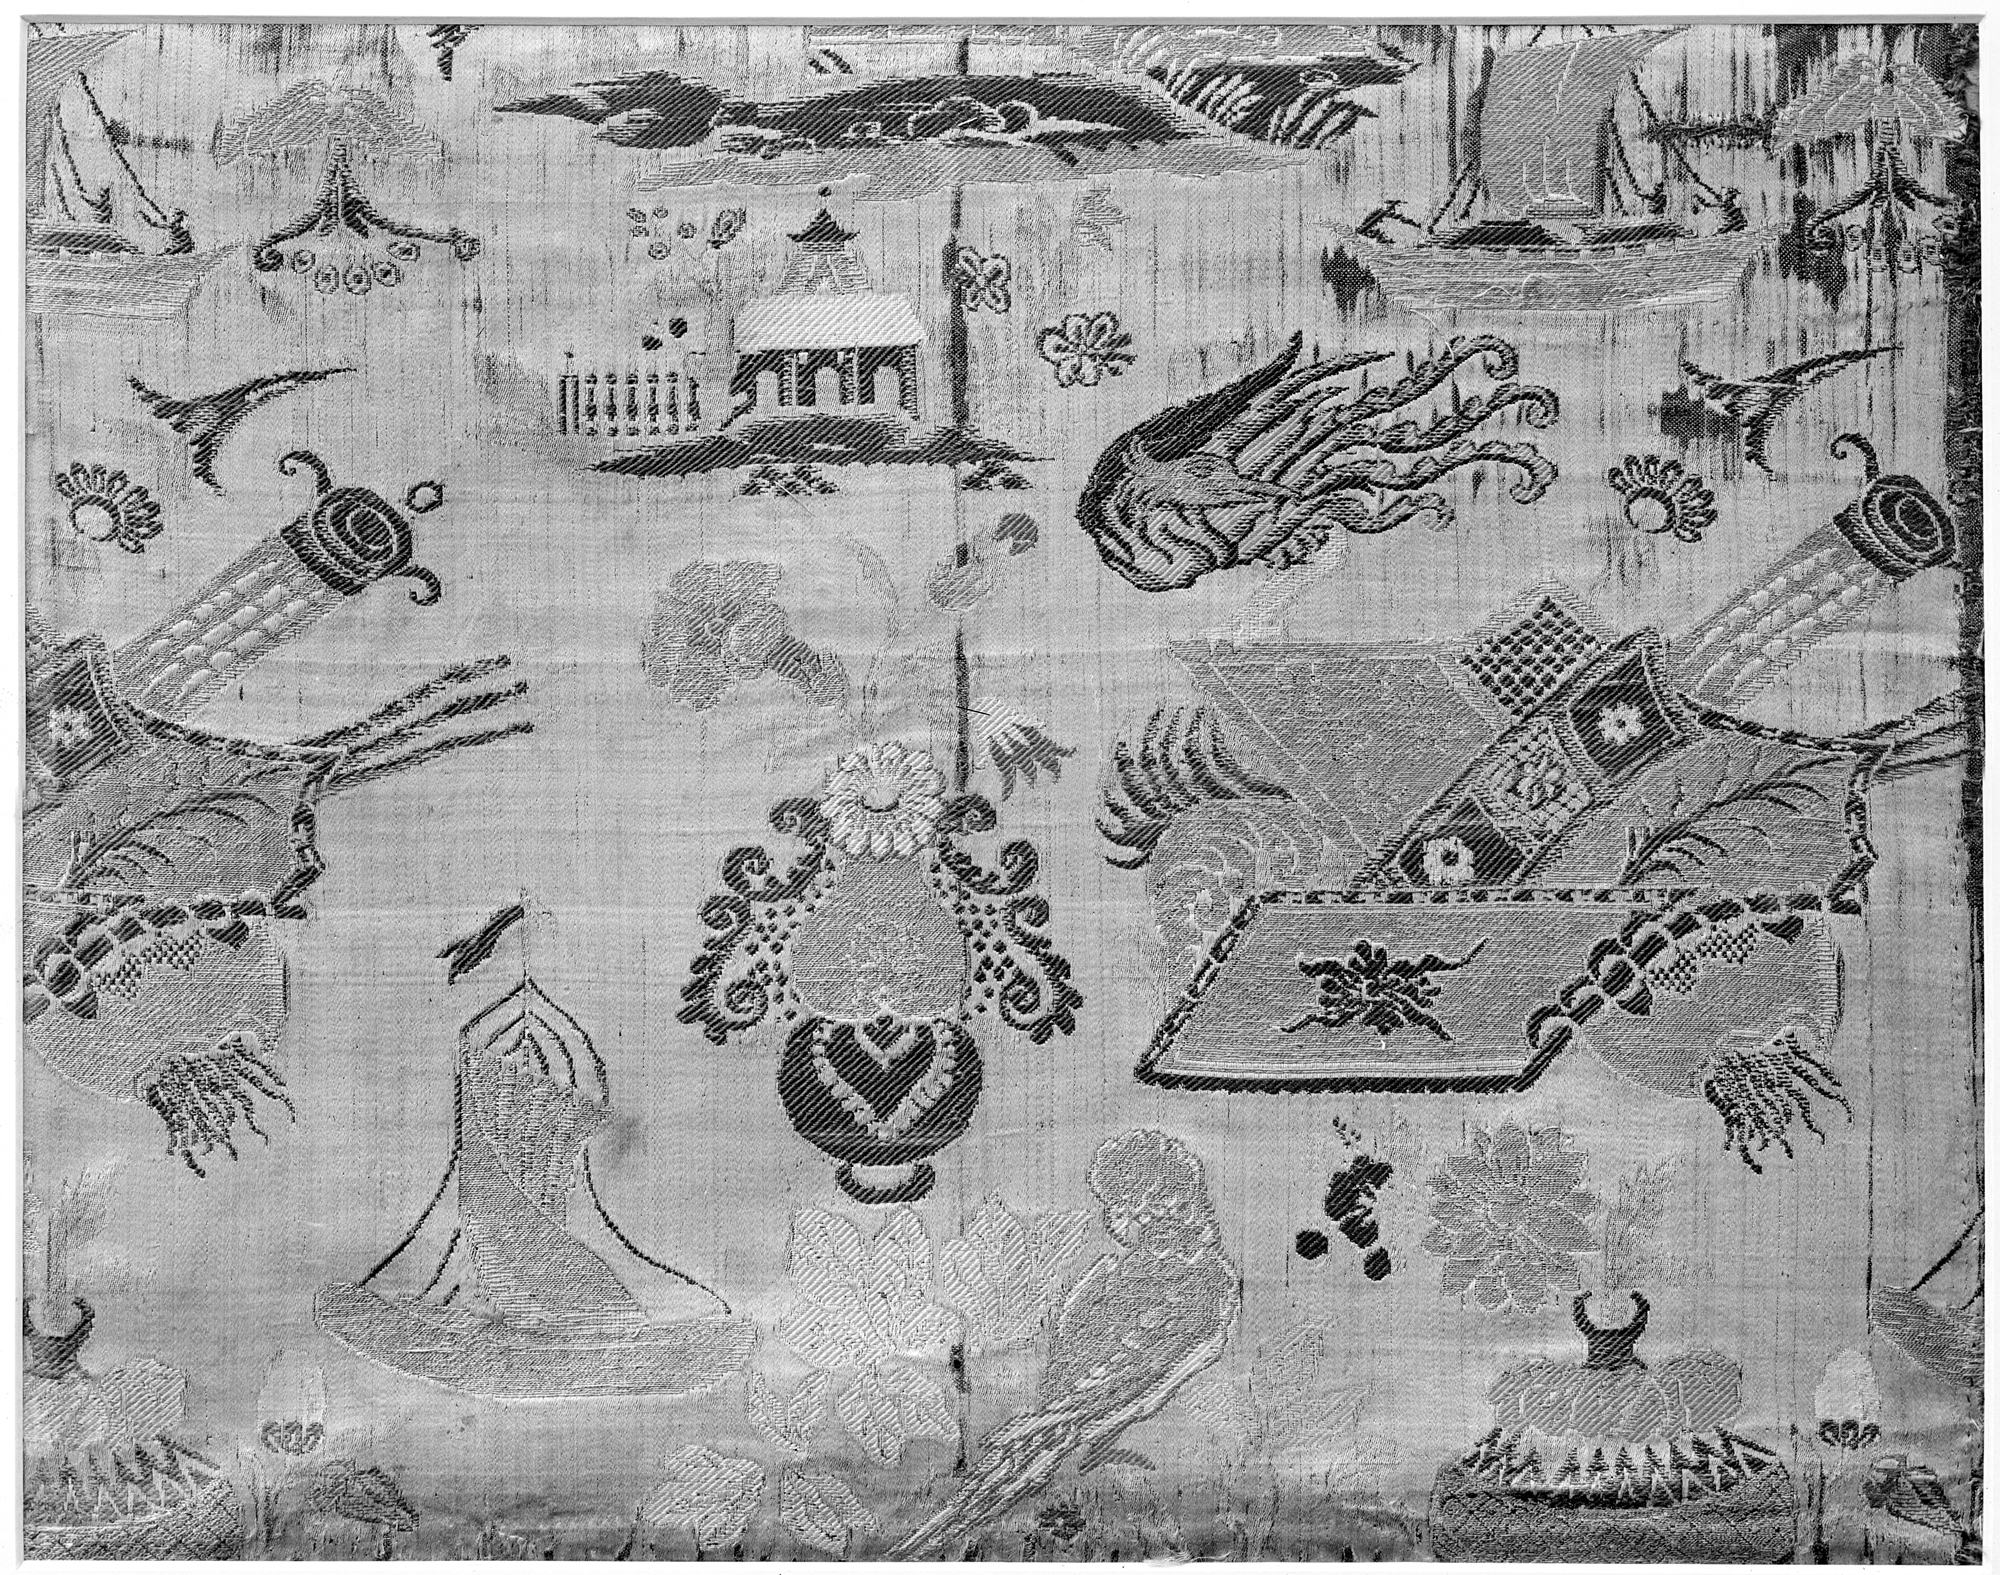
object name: piece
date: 1734-1766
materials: metal thread, silk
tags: birds,flowers,boats